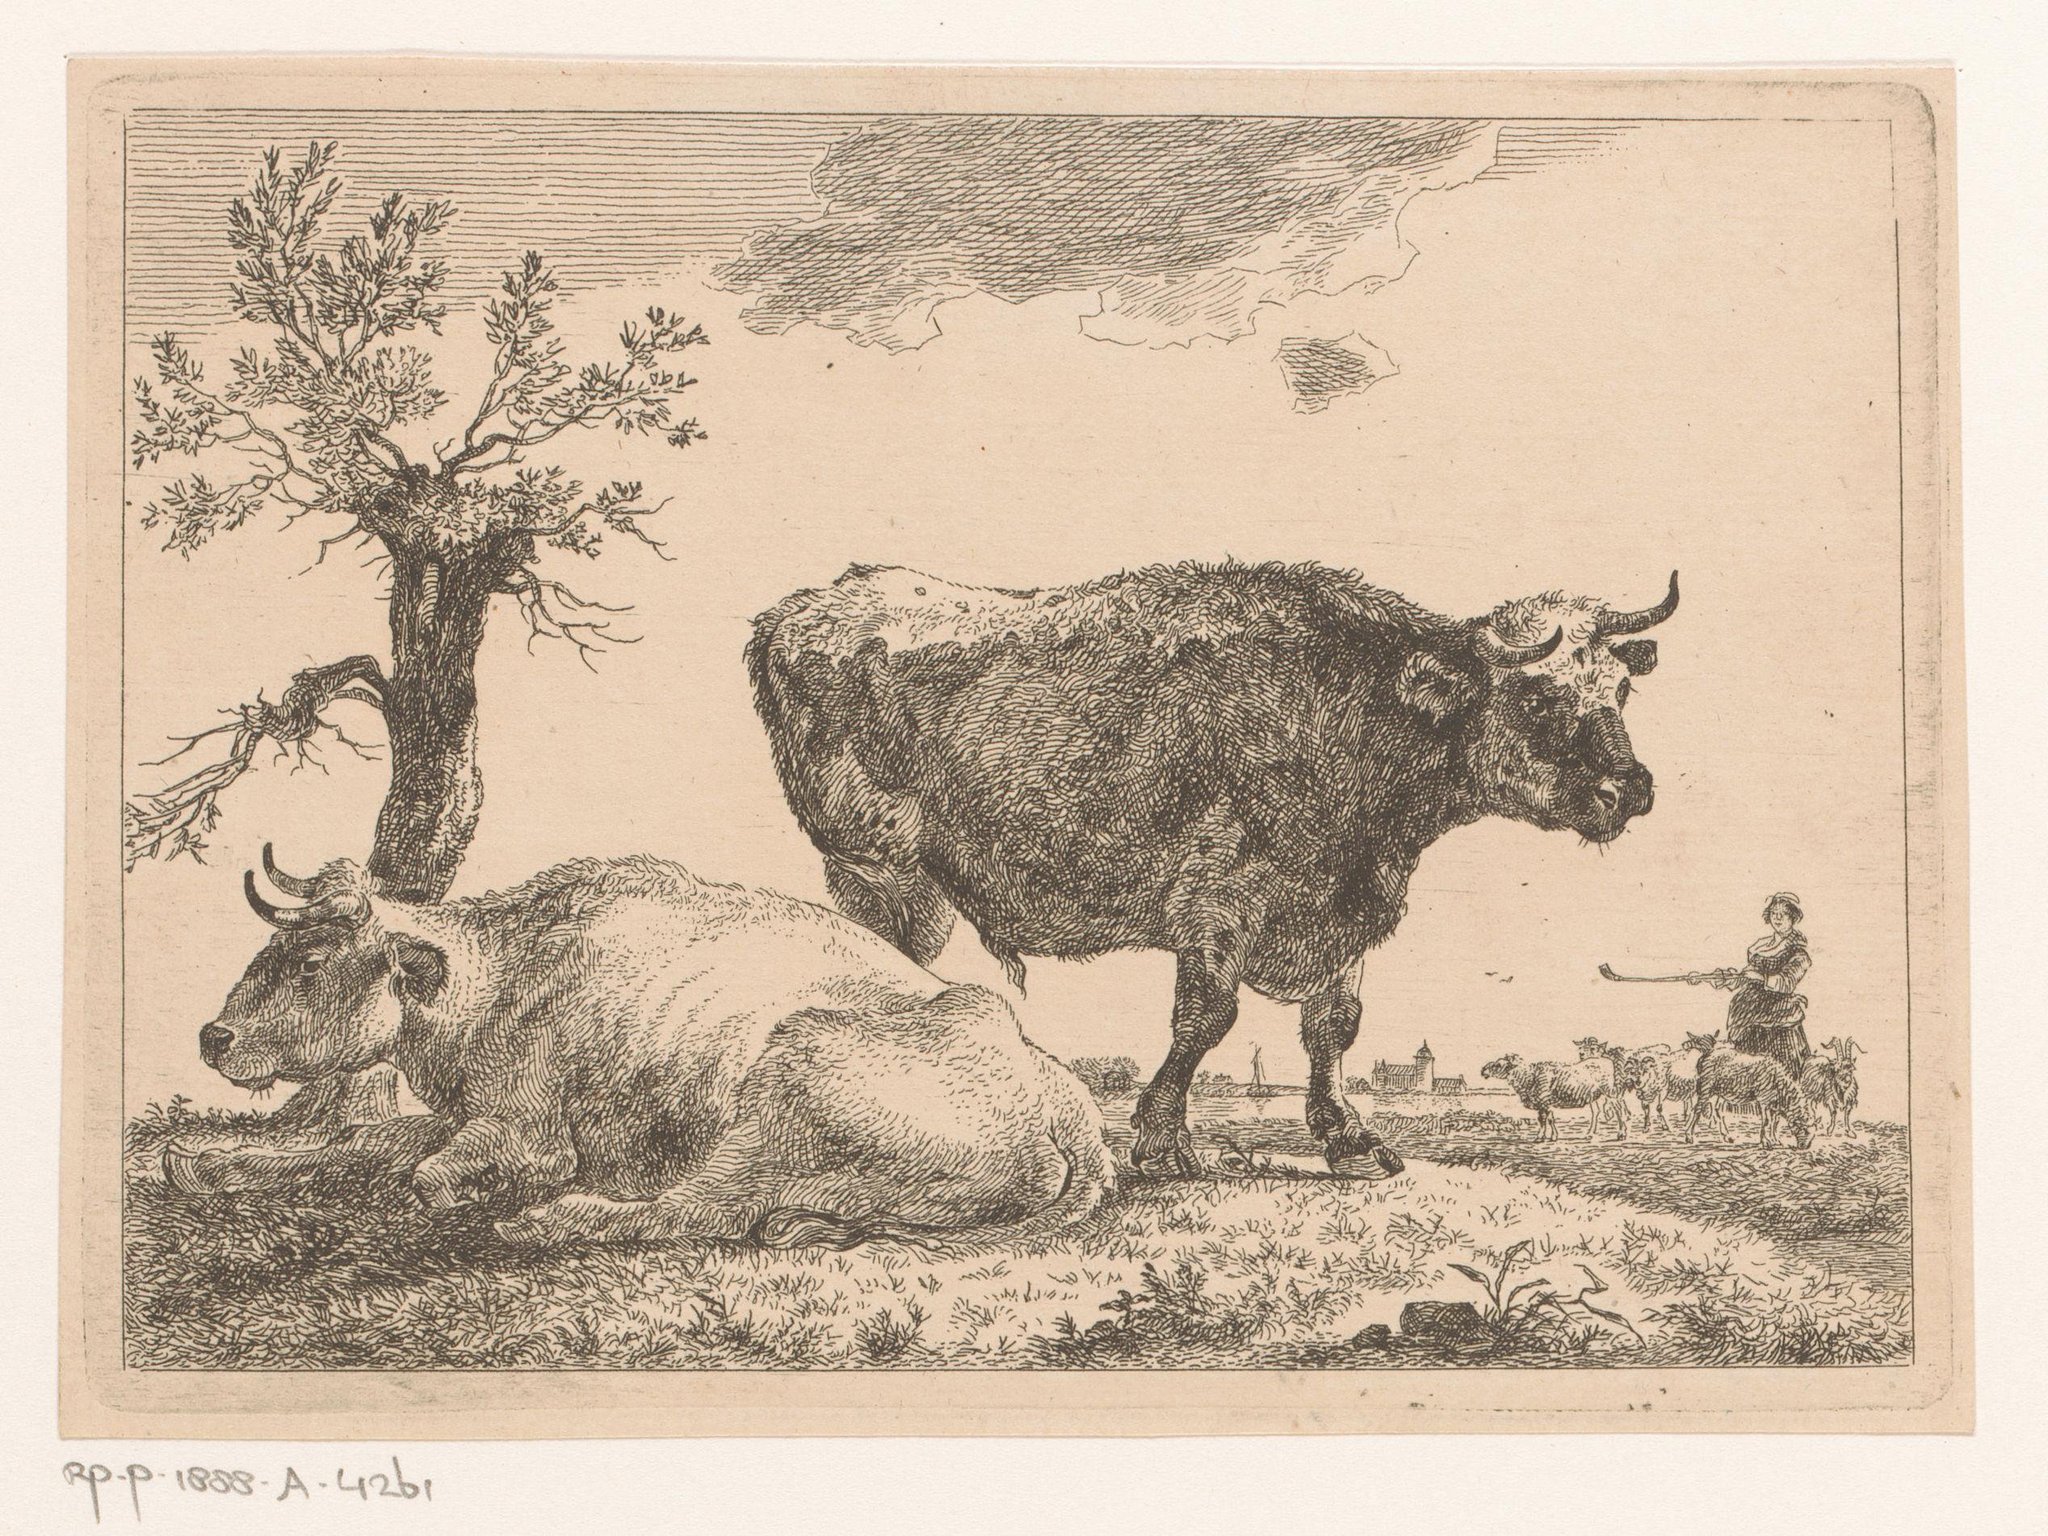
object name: print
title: Twee runderen bij een knotwilg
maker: jean baptiste de roy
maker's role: print maker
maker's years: 1759-1839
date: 1769-1839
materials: paper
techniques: etching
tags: cow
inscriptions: collector's mark: Lugt 2228